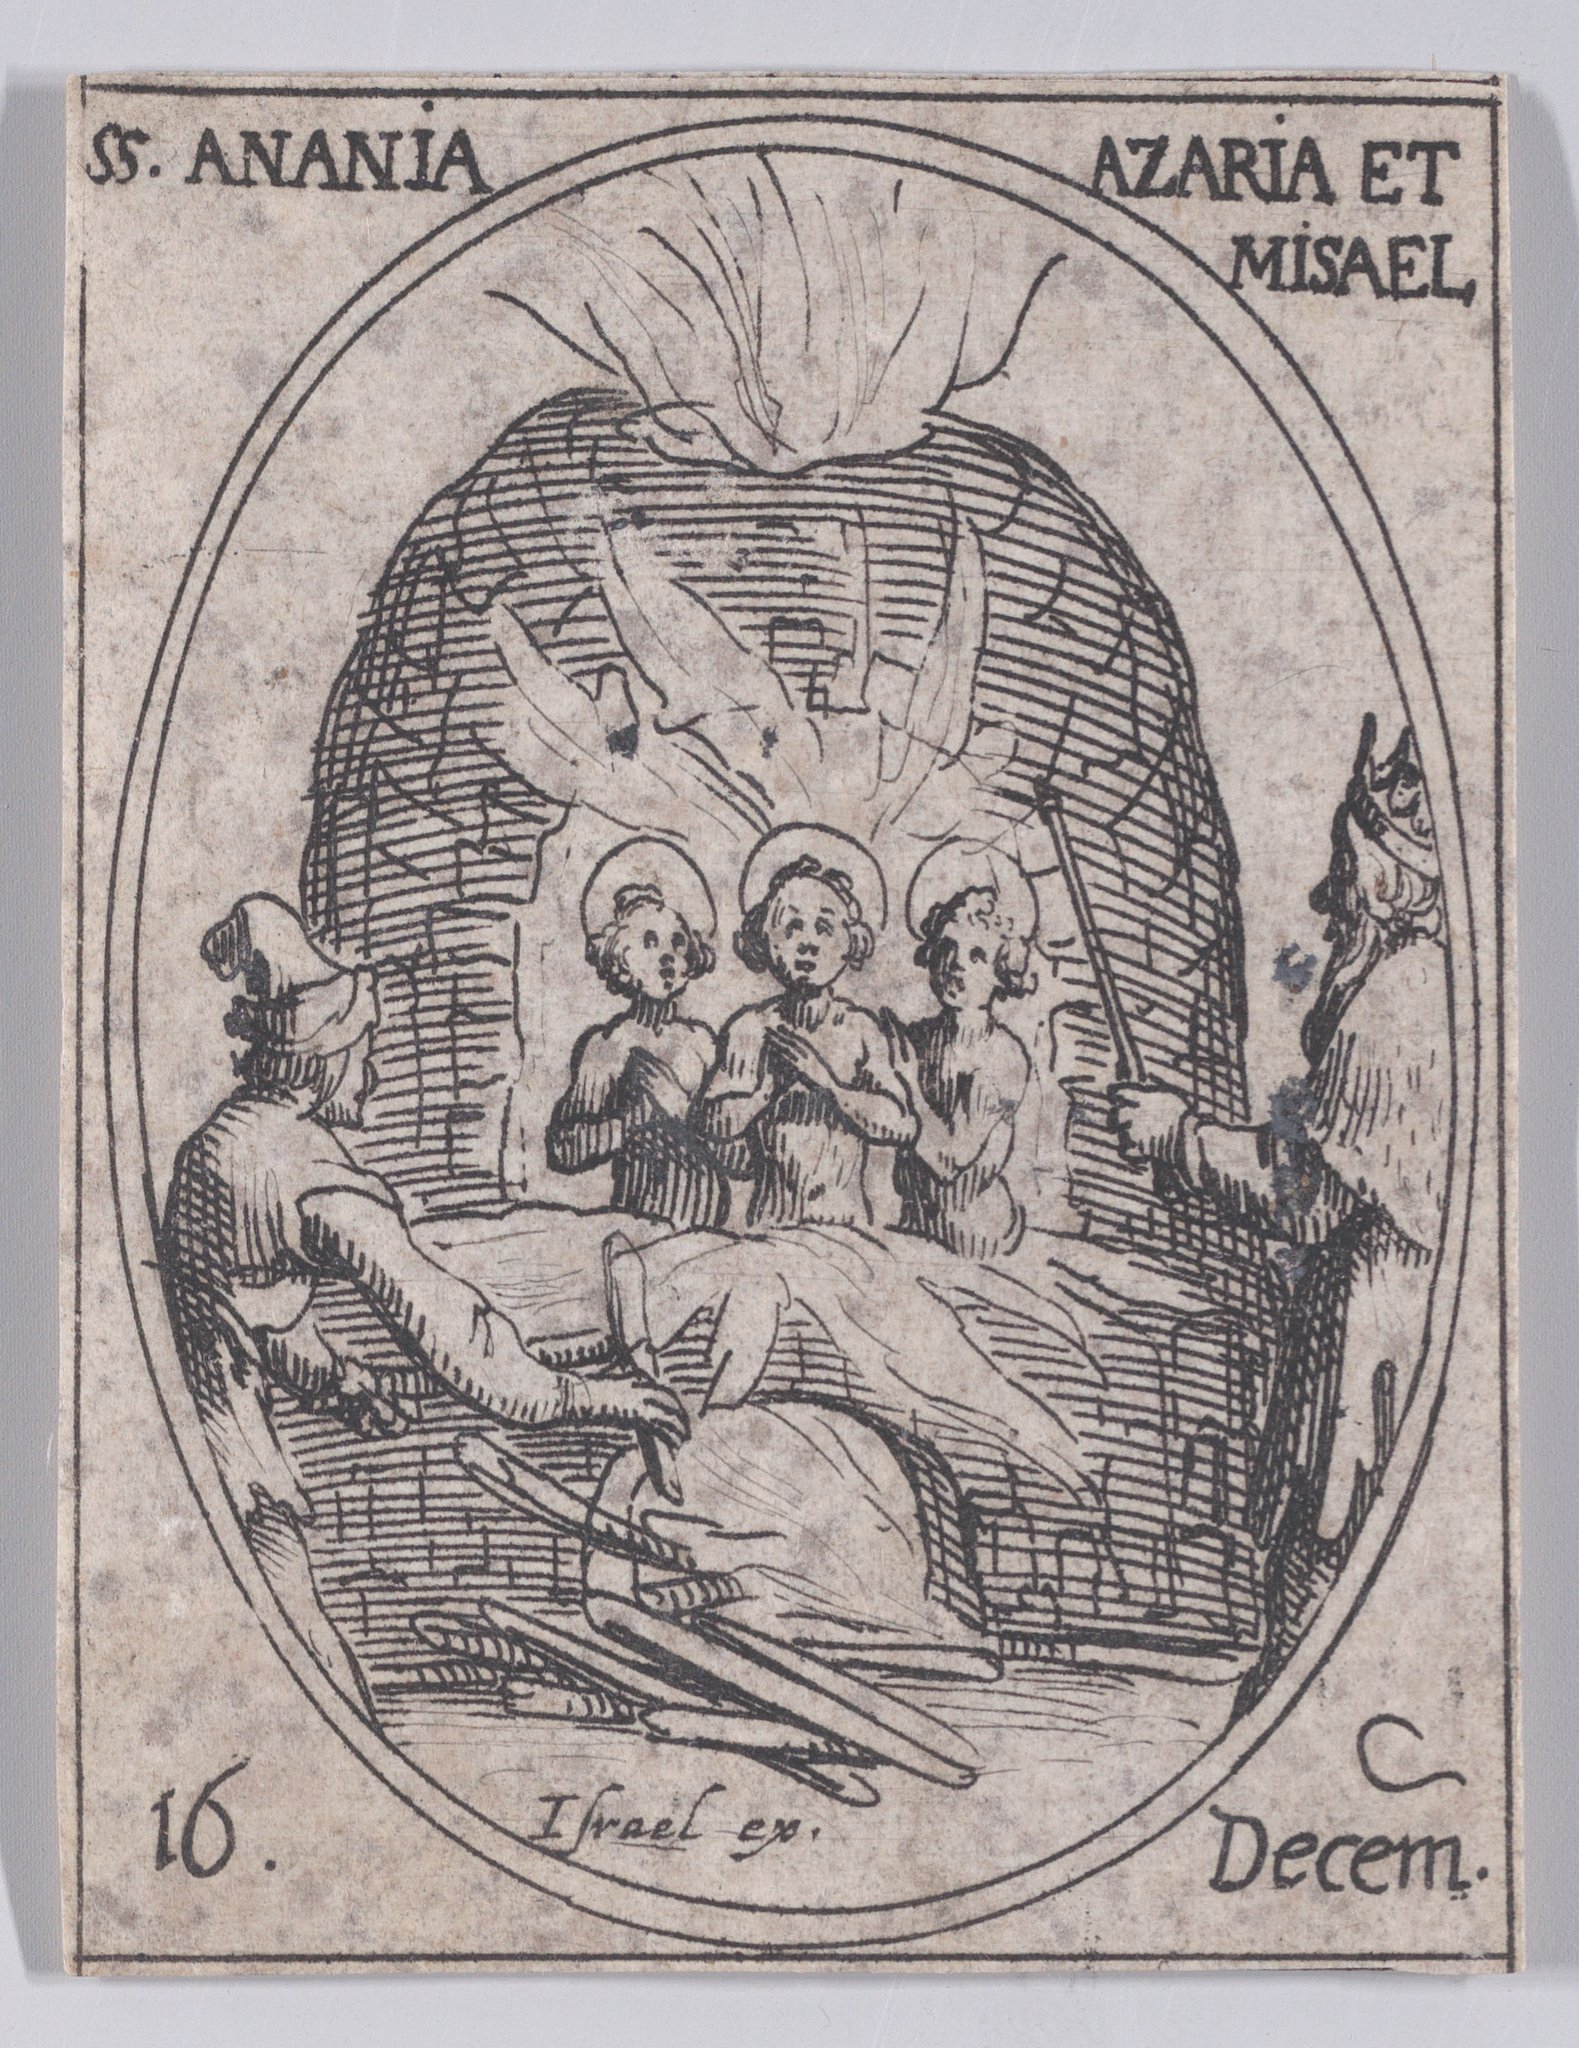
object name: print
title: S. Ananie, S. Azarie et S. Misaël (St. Ananias, St. Azarius, and St. Misael), December 16th, from "Les Images De Tous Les Saincts et Saintes de L'Année" (Images of All of the Saints and Religious Events of the Year)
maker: jacques callot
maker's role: artist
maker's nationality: french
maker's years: 1592-1635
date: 1636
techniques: etching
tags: men,fire,saints